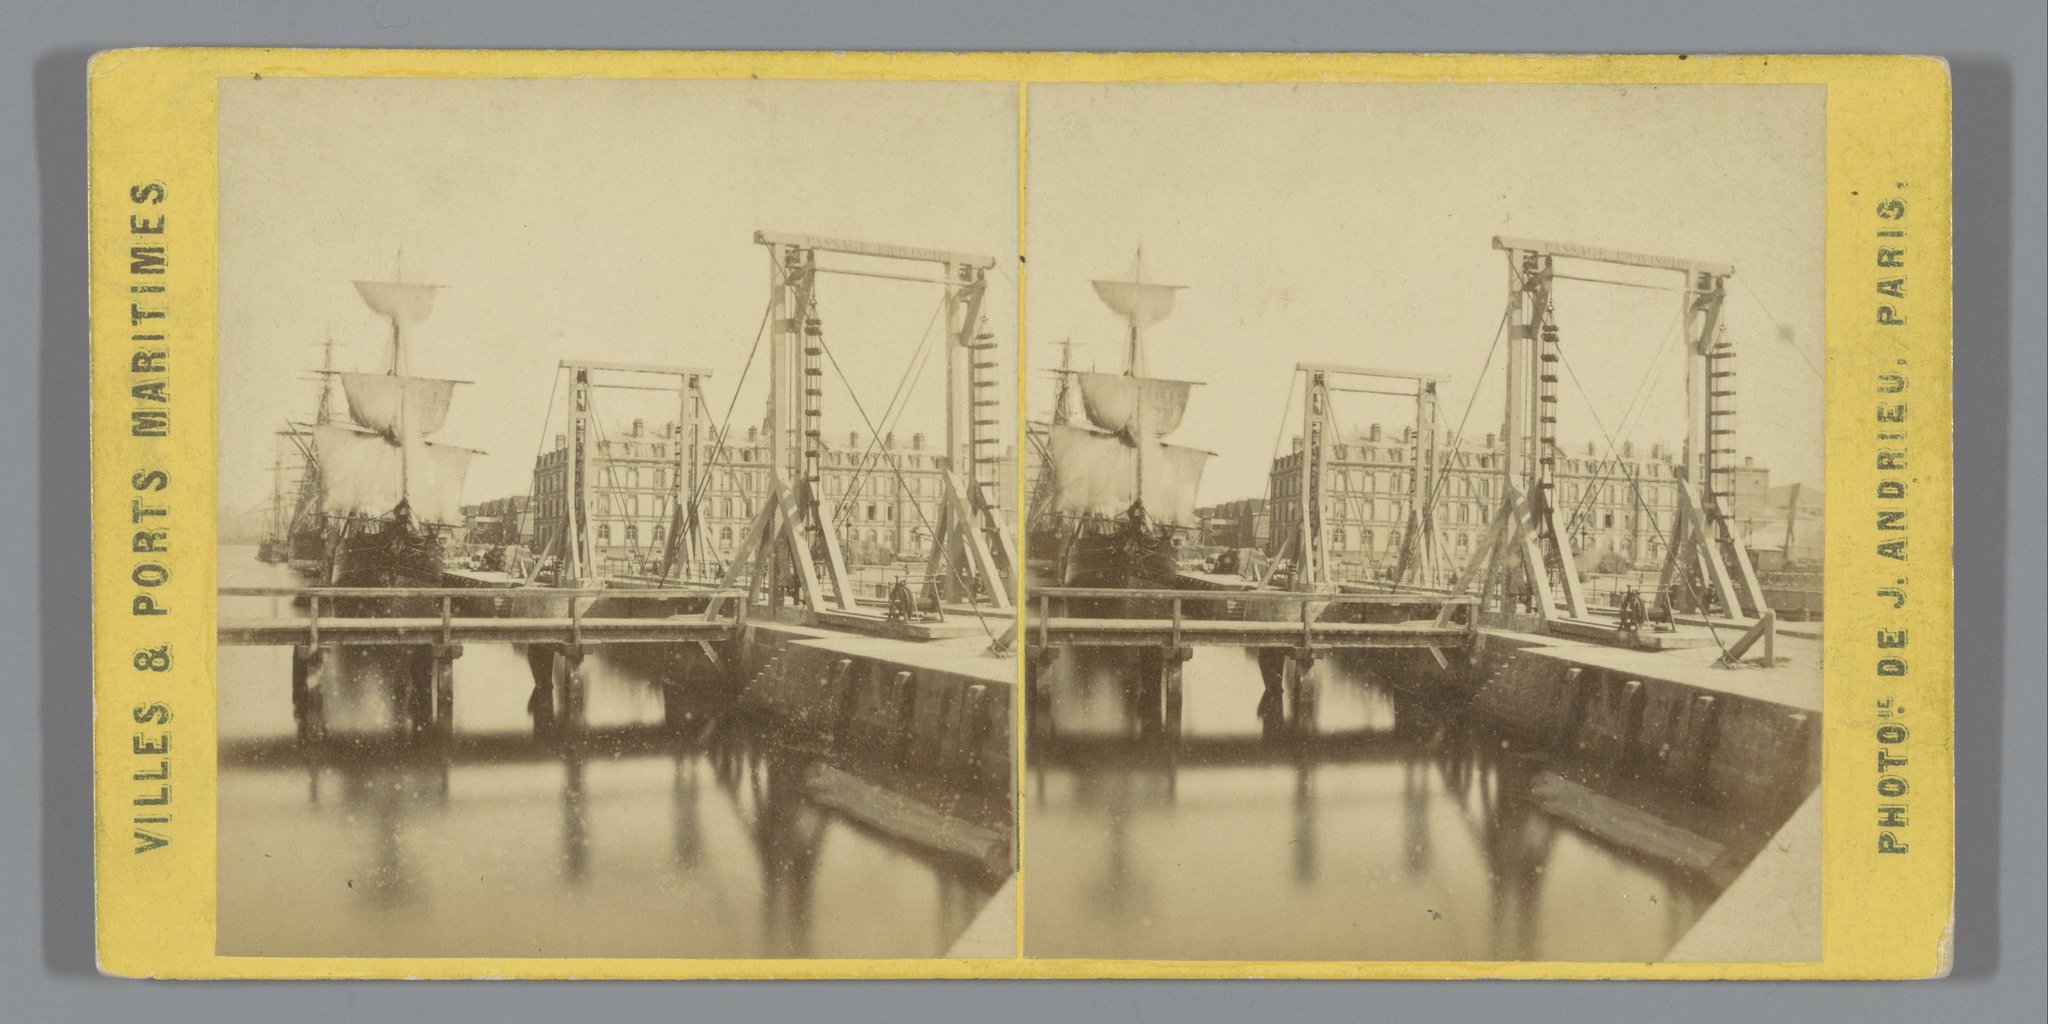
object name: stereograph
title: Villes & ports maritimes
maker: jean andrieu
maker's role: fotograaf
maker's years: 1816-1872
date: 1862-1876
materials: cardboard, photographic support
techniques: albumen print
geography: le havre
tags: sailing-ship, sailing-boat, pier, quay, wharf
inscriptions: number: ‘429’